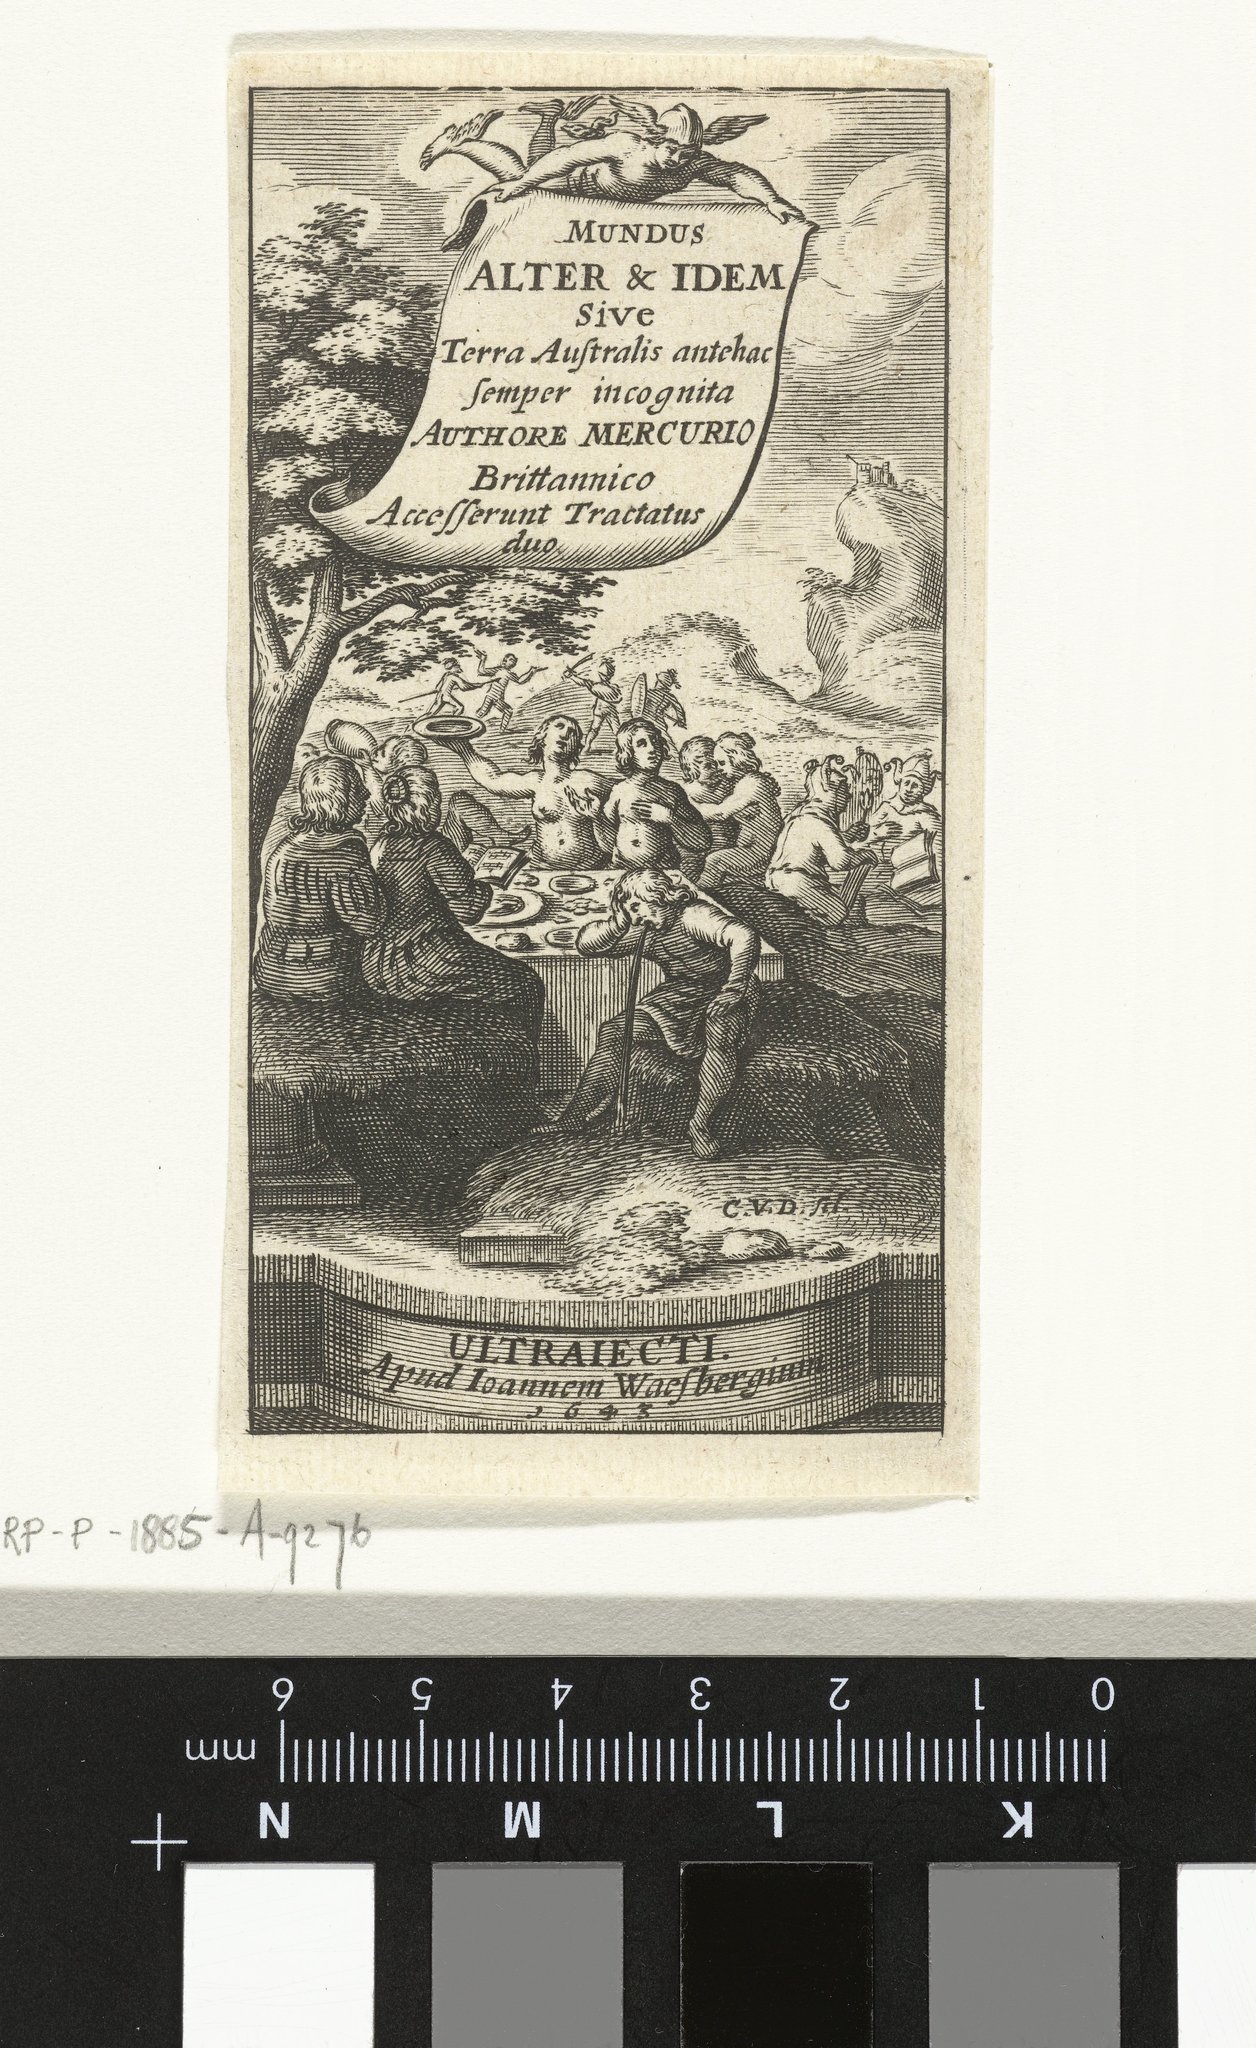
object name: print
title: Zingend echtpaar aan tafel bij gezelschap dat eet en drinkt in overvloed in landschap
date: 1643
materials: paper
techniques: engraving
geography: utrecht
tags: (story of) mercury (hermes), private festivities, merry company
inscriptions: collector's mark: Lugt 2228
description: Een man en vrouw zingen met een liedboek voor zich terwijl het gezelschap aan tafel zich te buiten gaat aan eten en drinken, een man geeft over, een naakte man en vrouw omhelzen elkaar en een groepje narren of dwazen met een boek is in gesprek. Boven de groep in het landschap zweeft Mercurius met een blad met de titel.